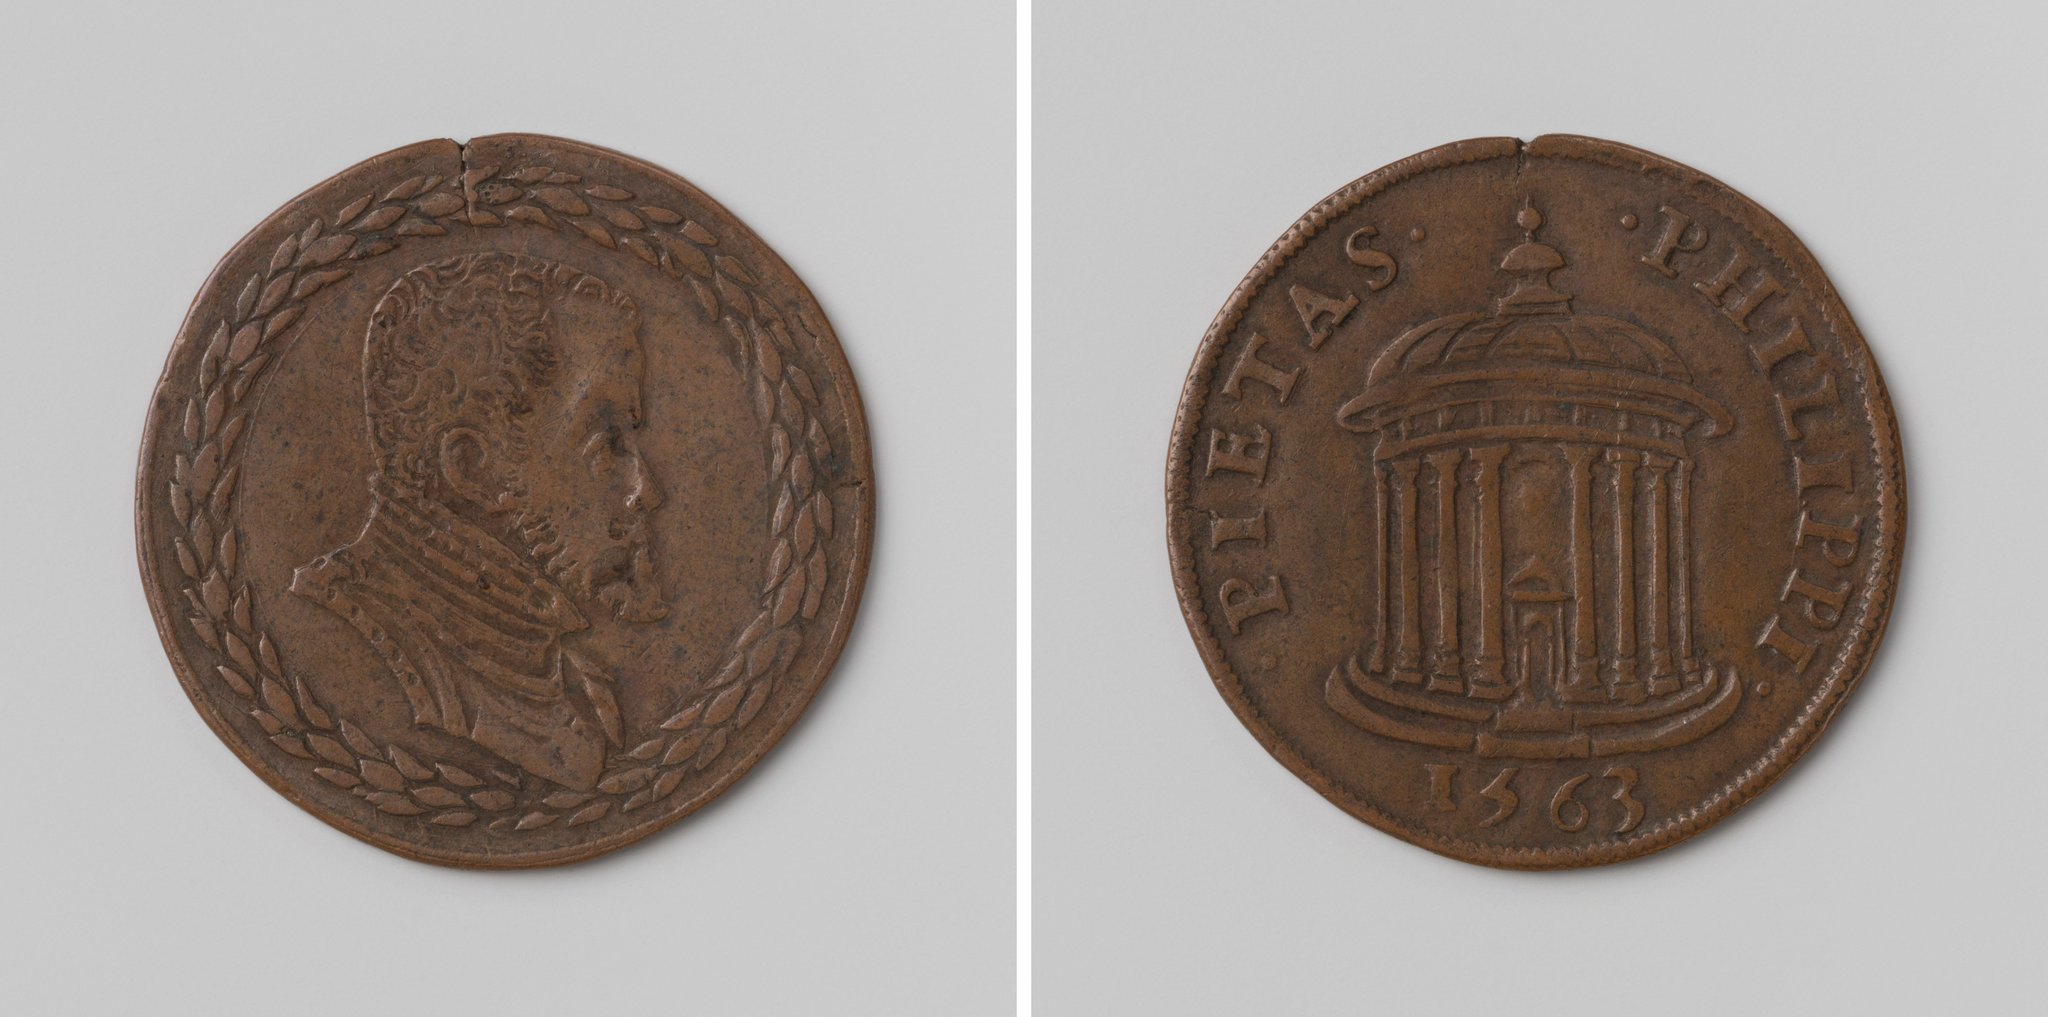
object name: jeton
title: Godsdienstigheid van Filips II, koning van Spanje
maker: Anonymous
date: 1563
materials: copper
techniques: striking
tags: philip ii of spain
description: Koperen penning. Voorzijde: borststuk man binnen lauwerkrans. Keerzijde: tempel binnen omschrift